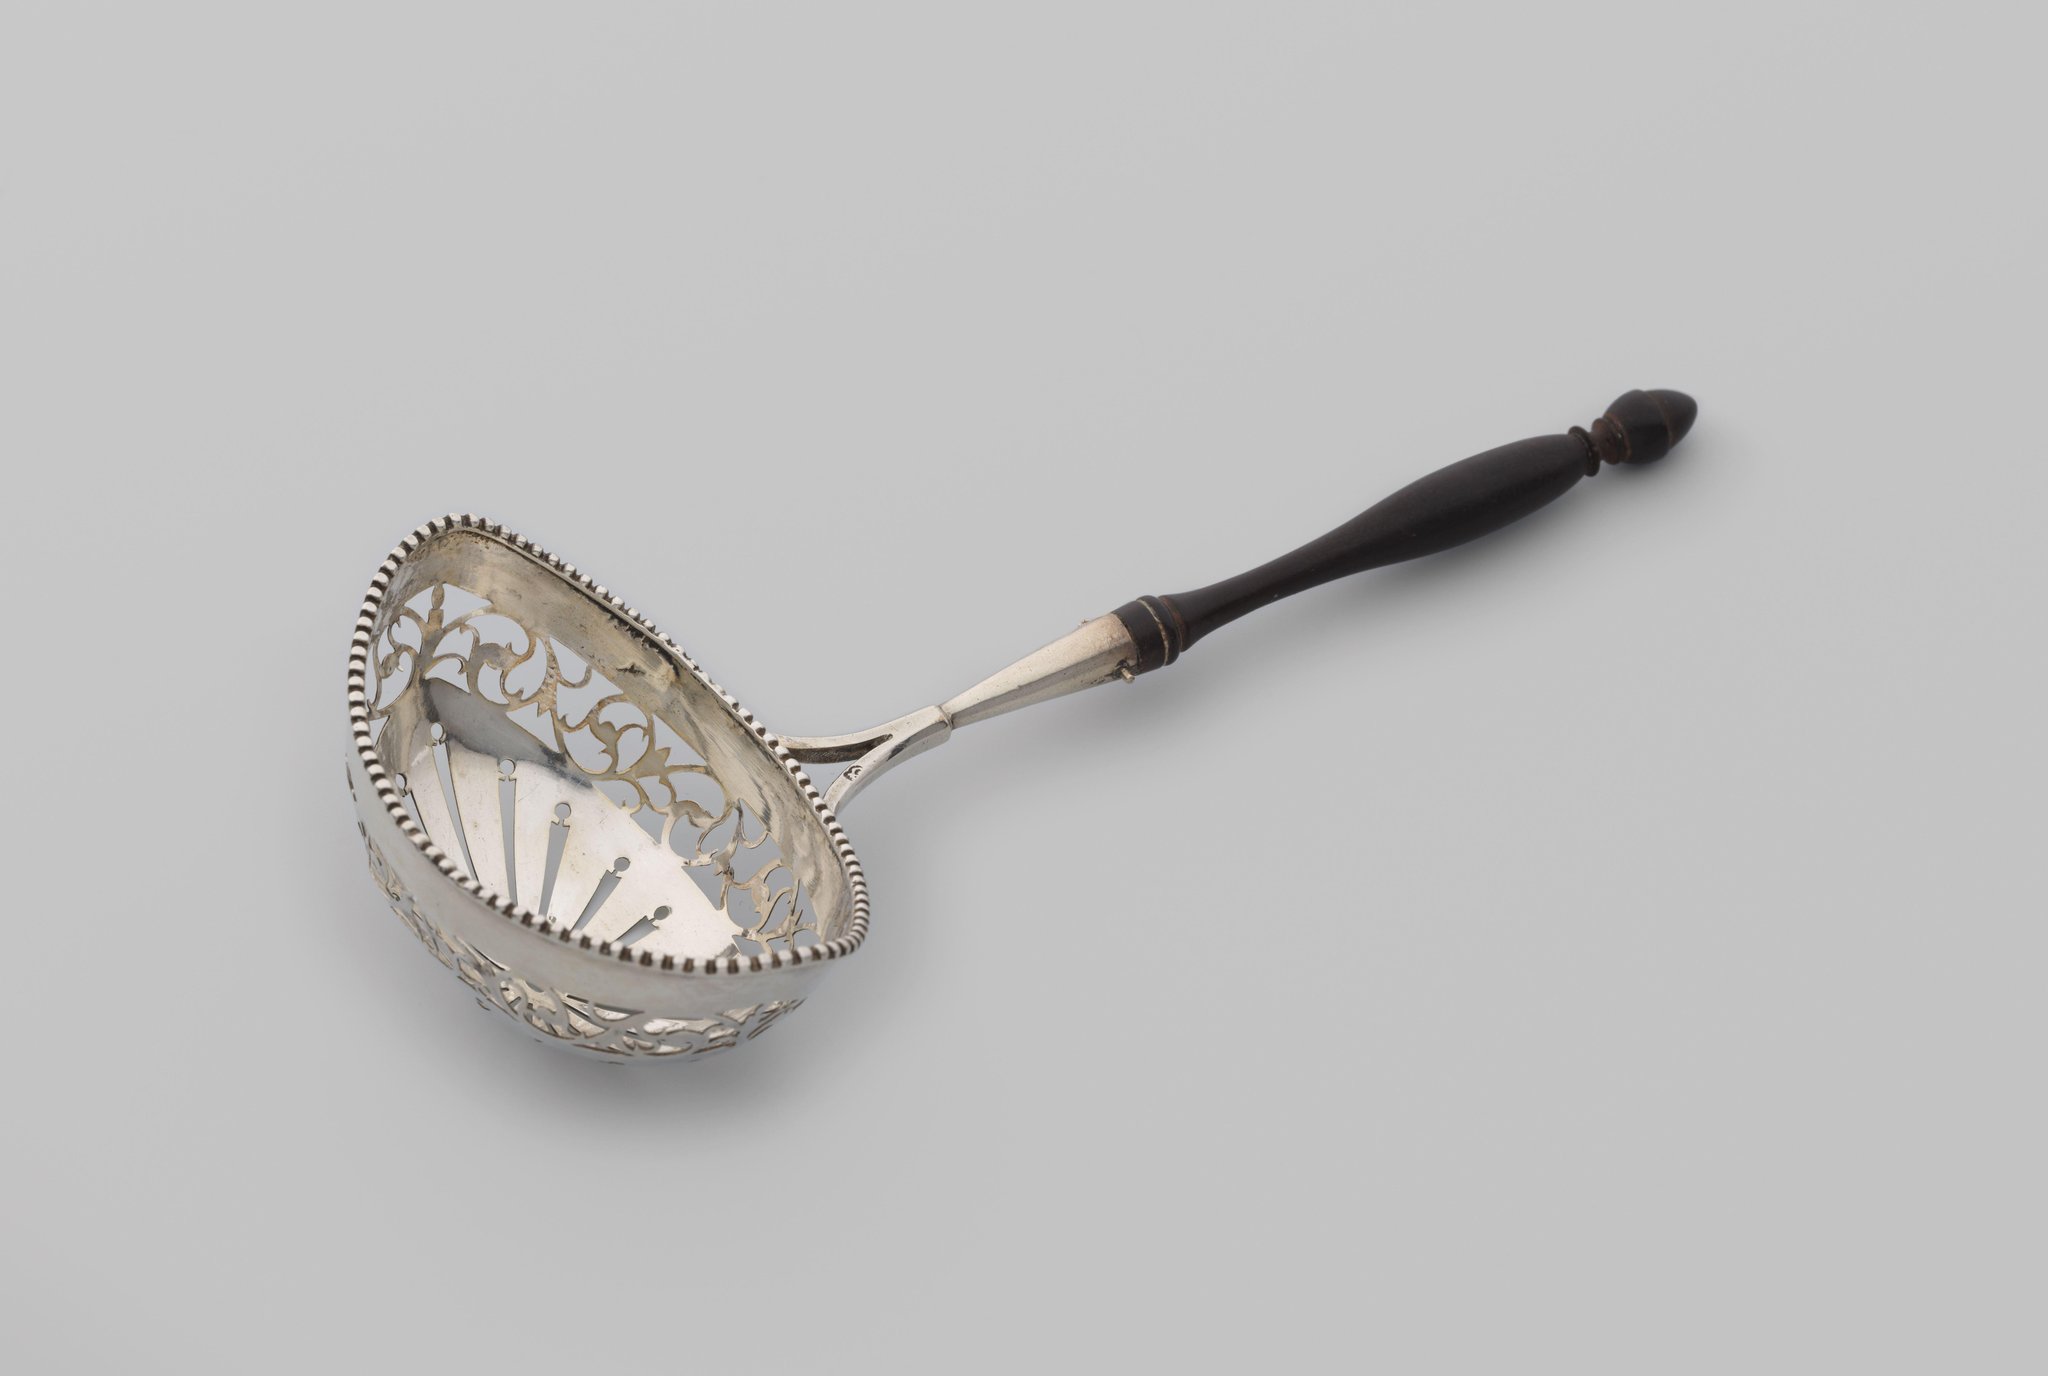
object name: spoon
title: Suikerstrooilepel met ovale, opengewerkte bak met parelrand en houten steel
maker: diederik willem rethmeyer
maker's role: silversmith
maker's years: 1756-1821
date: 1805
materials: wood, silver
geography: amsterdam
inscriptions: date letter: ‘W’, town mark, maker's mark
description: De diepe ovale bak is omgeven door een opgelegde parelrand. Hij is opengewerkt met een patroon van een kleine ovaal binnen een krans van door knoppen bekroonde stralen met daaromheen een rand van gestileerde bladranken. De gedraaide houten, balustervormige steel, die wordt bekroond door een eikelvormige knop, is van de V-vormige aanzet gescheiden door een rond, zich verbredend zilveren verbindingsstuk, waaraan hij met een pen is bevestigd.